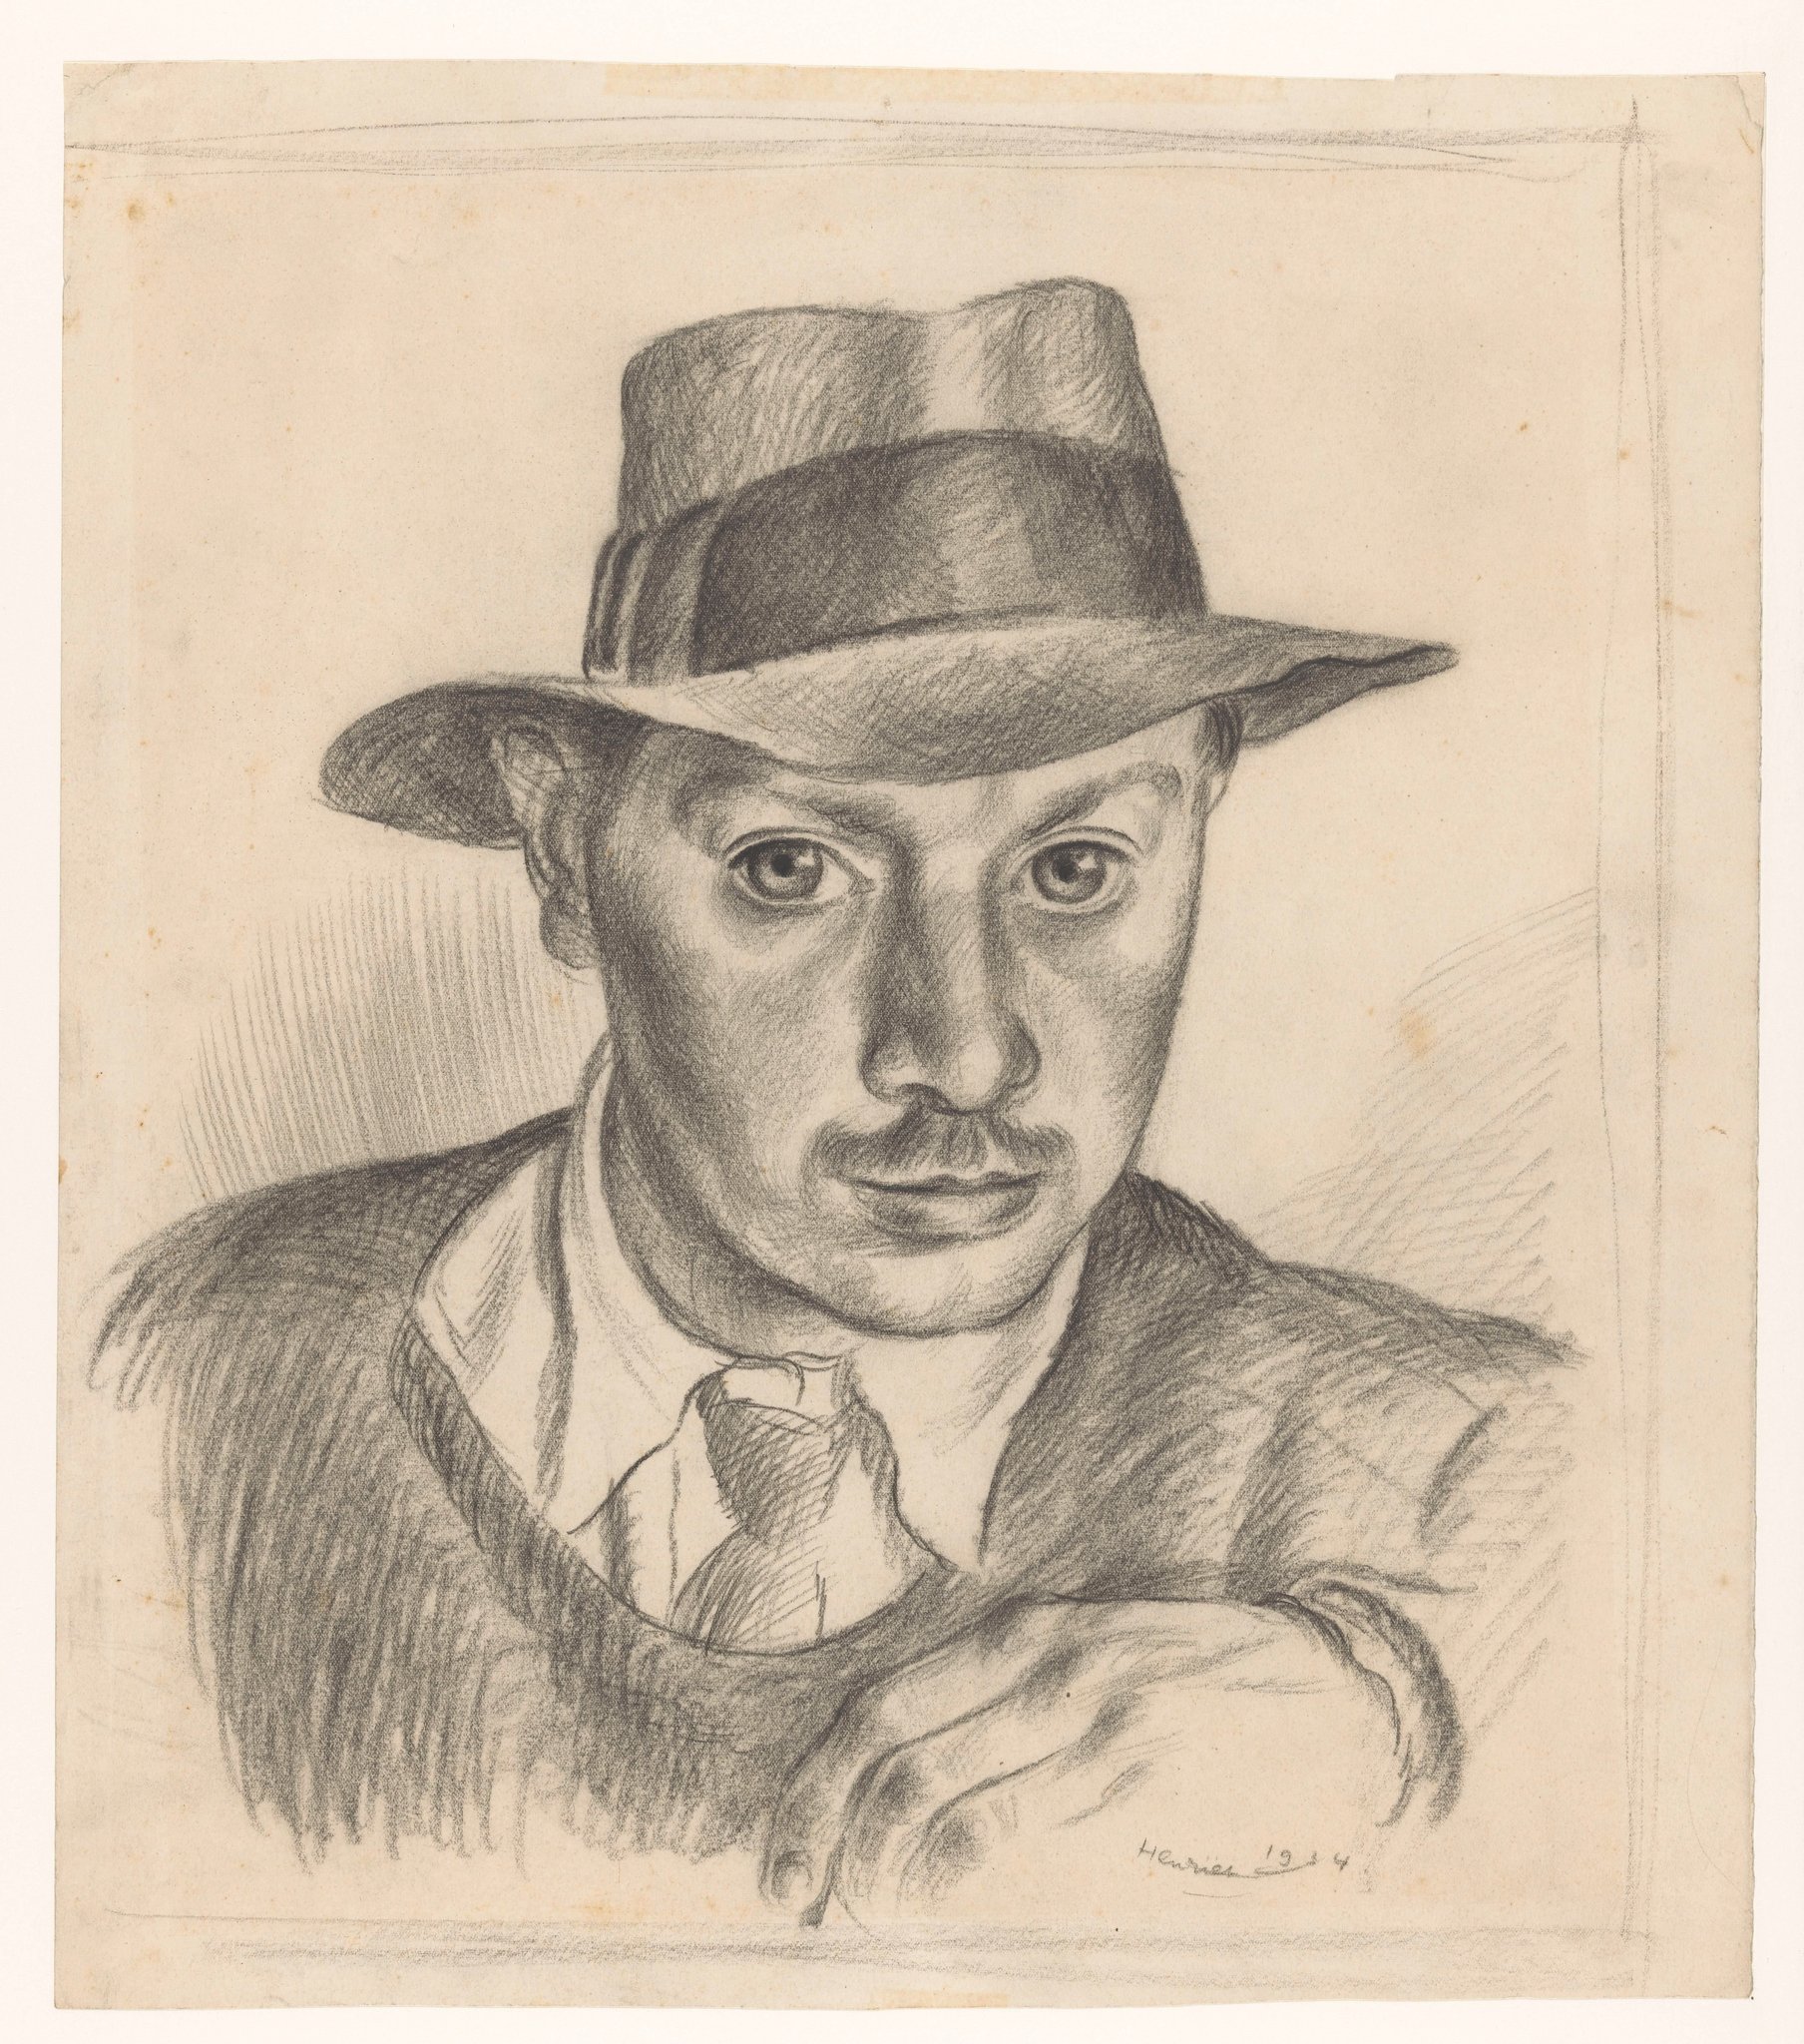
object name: drawing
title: Portret van een onbekende man met een hoed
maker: henk henriët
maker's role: draughtsman, print maker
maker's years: 1903-1945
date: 1934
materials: chalk, paper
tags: head-gear: hat, anonymous historical person portrayed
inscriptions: workshop stamp: ‘Atelier H. Henriët’, inscription: ‘No 61 J.J.H.’, collector's mark: Lugt 2228